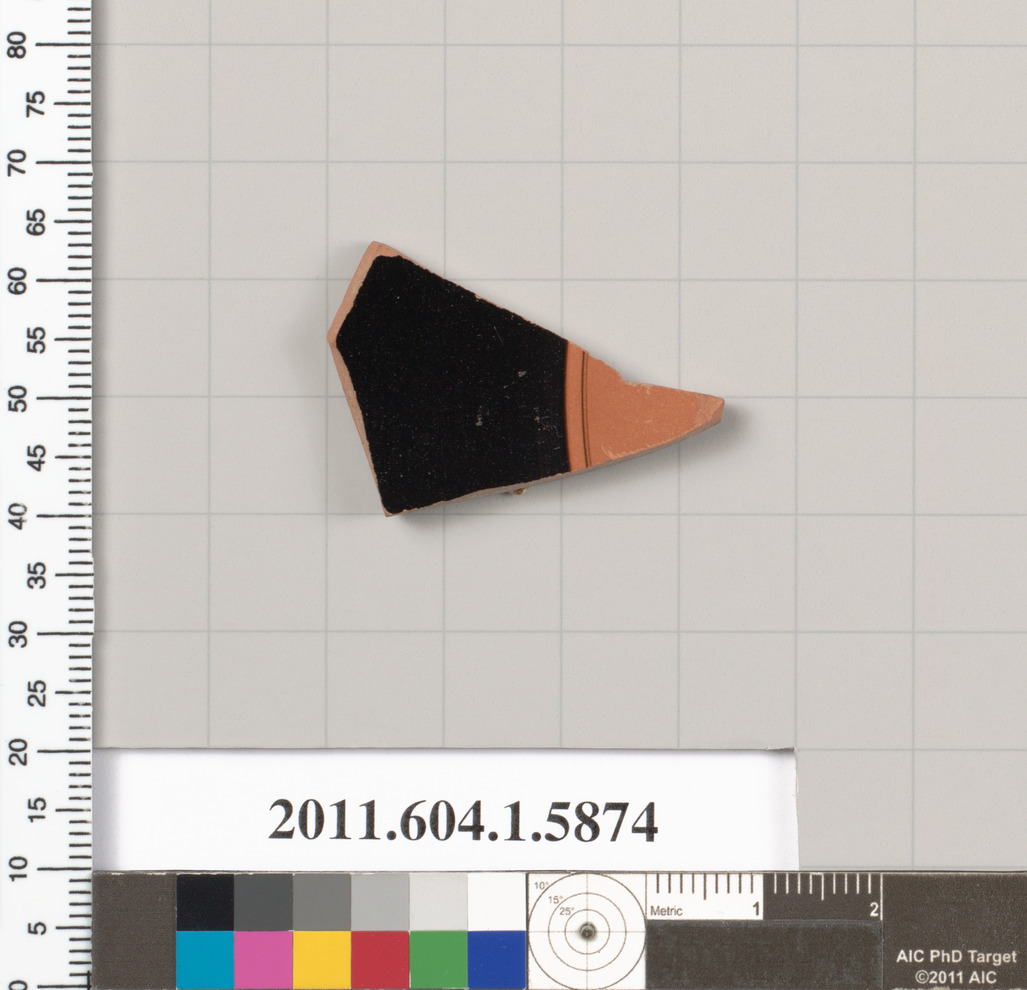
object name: kylix fragment, eye cup, bilingual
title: Terracotta fragment of a kylix (drinking cup)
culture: greek, attic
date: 433-567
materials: terracotta